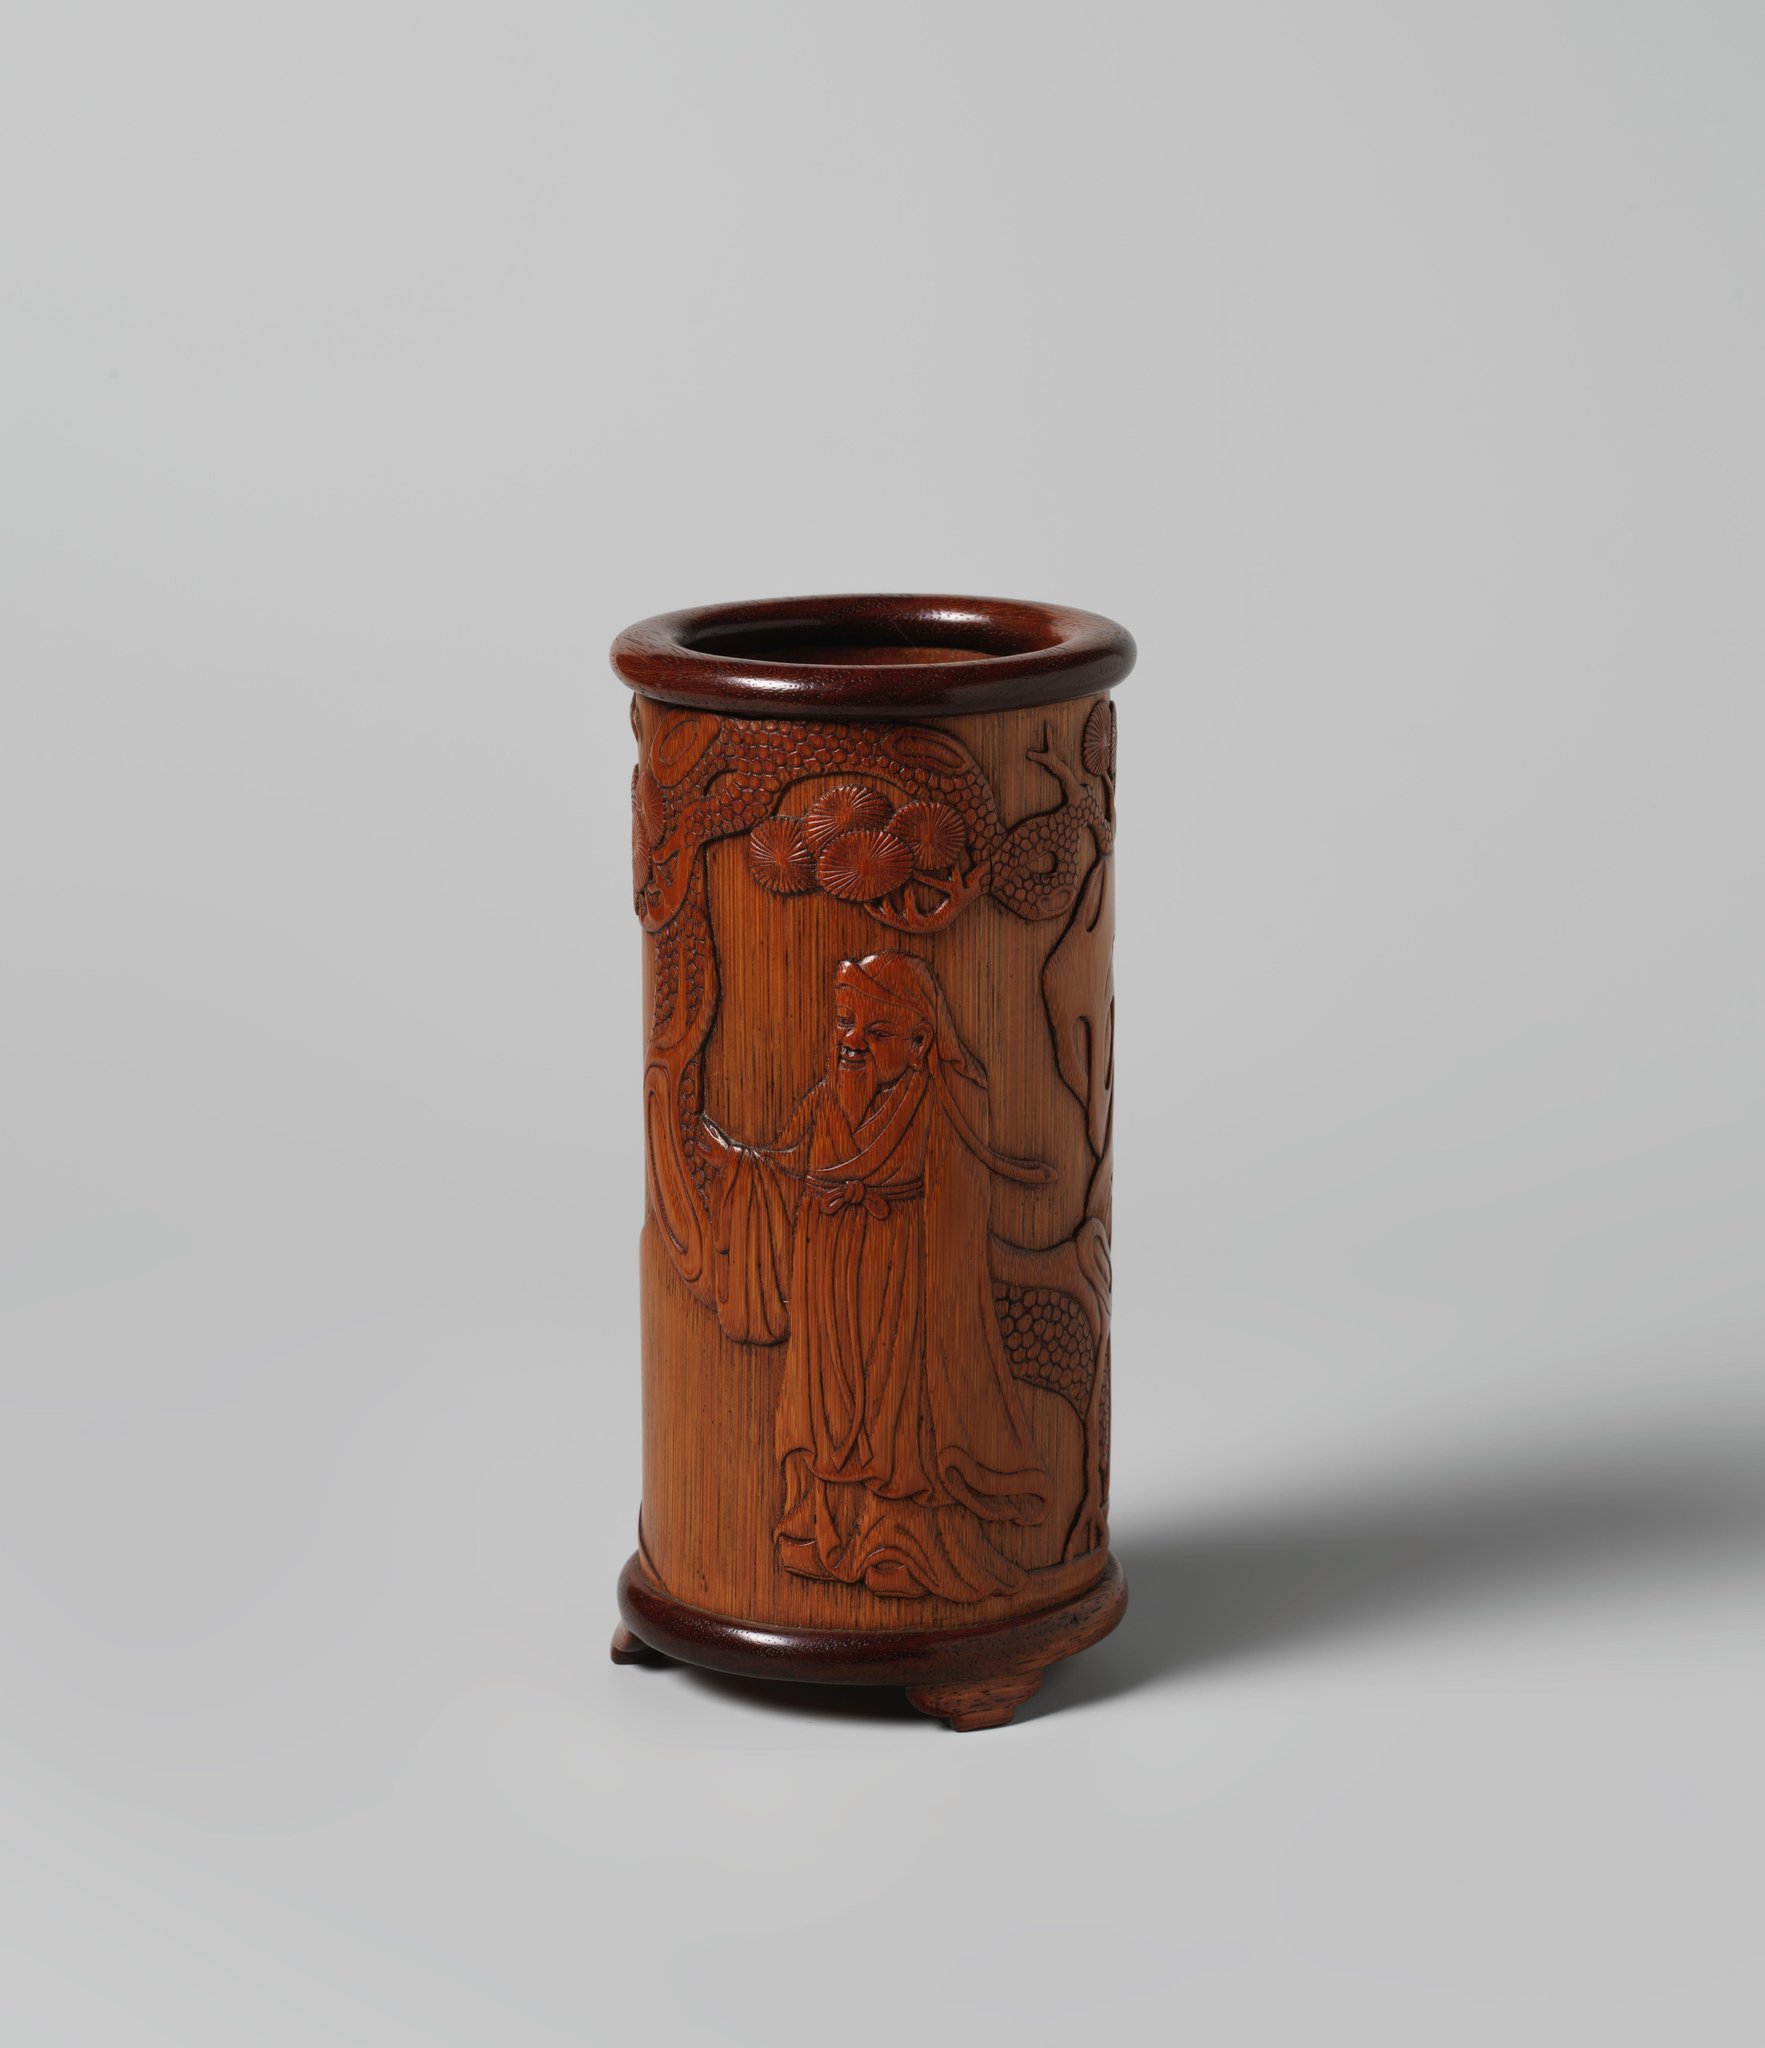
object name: brush holder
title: Brush holder decorated with the story of Tao Yuanming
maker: danian ma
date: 1644-1911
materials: bamboo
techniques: cutting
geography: china